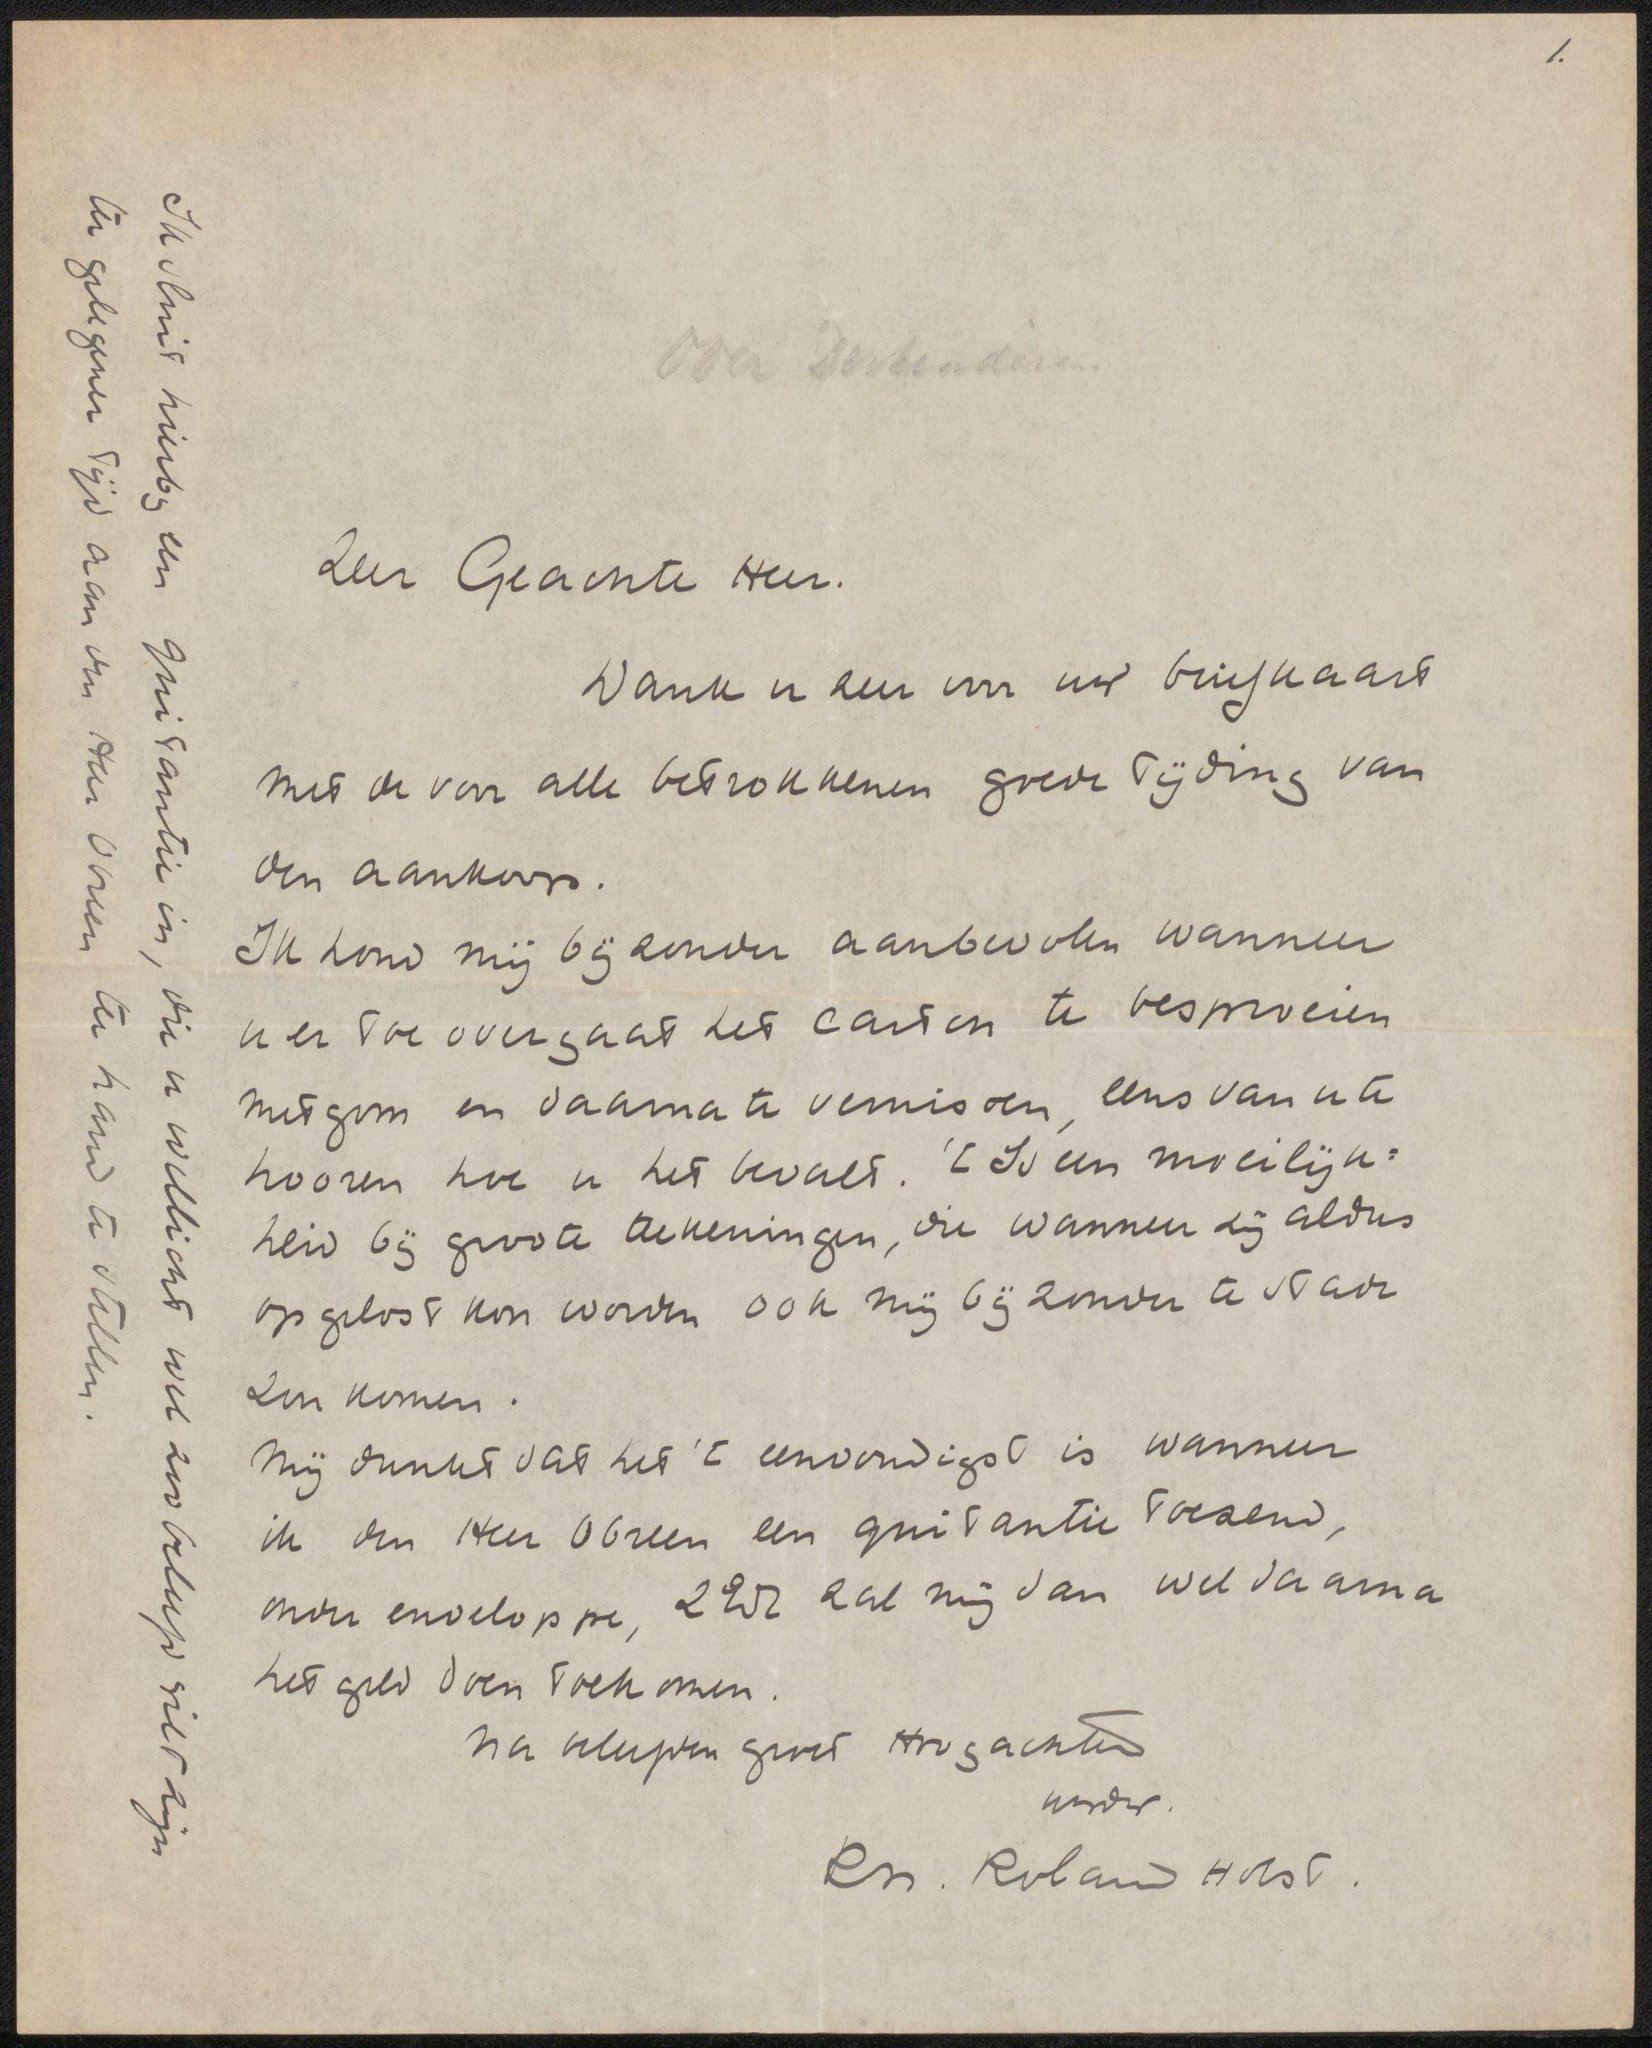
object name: letter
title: Brief aan anoniem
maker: richard nicolaüs roland holst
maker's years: 1868-1938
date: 1878-1938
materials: ink, paper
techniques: pen, writing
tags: drawing, applied arts, arts and crafts; industrial design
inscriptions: collector's mark: ‘RPK’